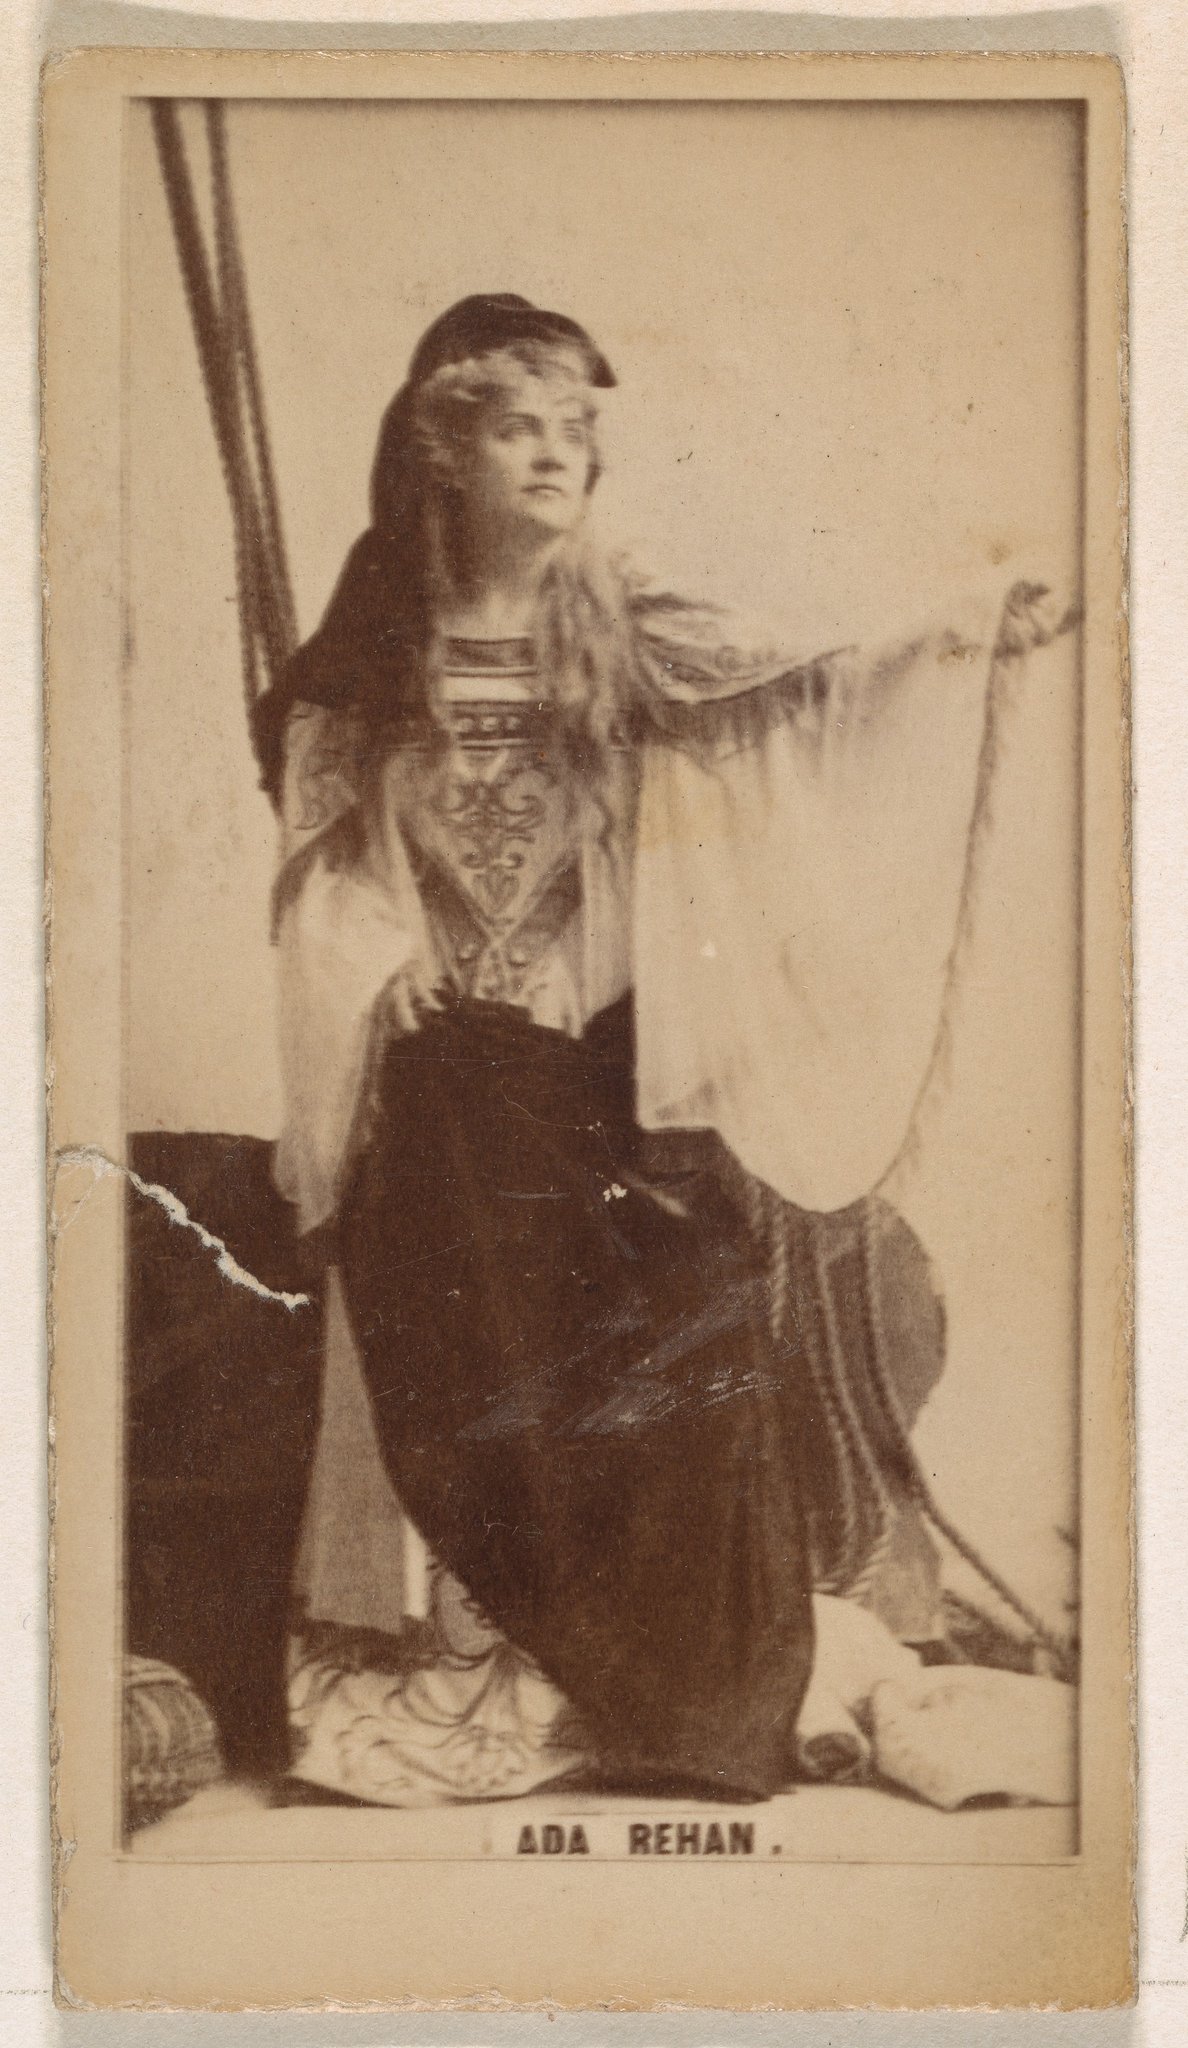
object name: photograph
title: Ada Rehan, from the Actresses series (N245) issued by Kinney Brothers to promote Sweet Caporal Cigarettes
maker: kinney brothers tobacco company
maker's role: publisher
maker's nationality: american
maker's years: 1869-2011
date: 1890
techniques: albumen silver print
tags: portraits,women,actresses